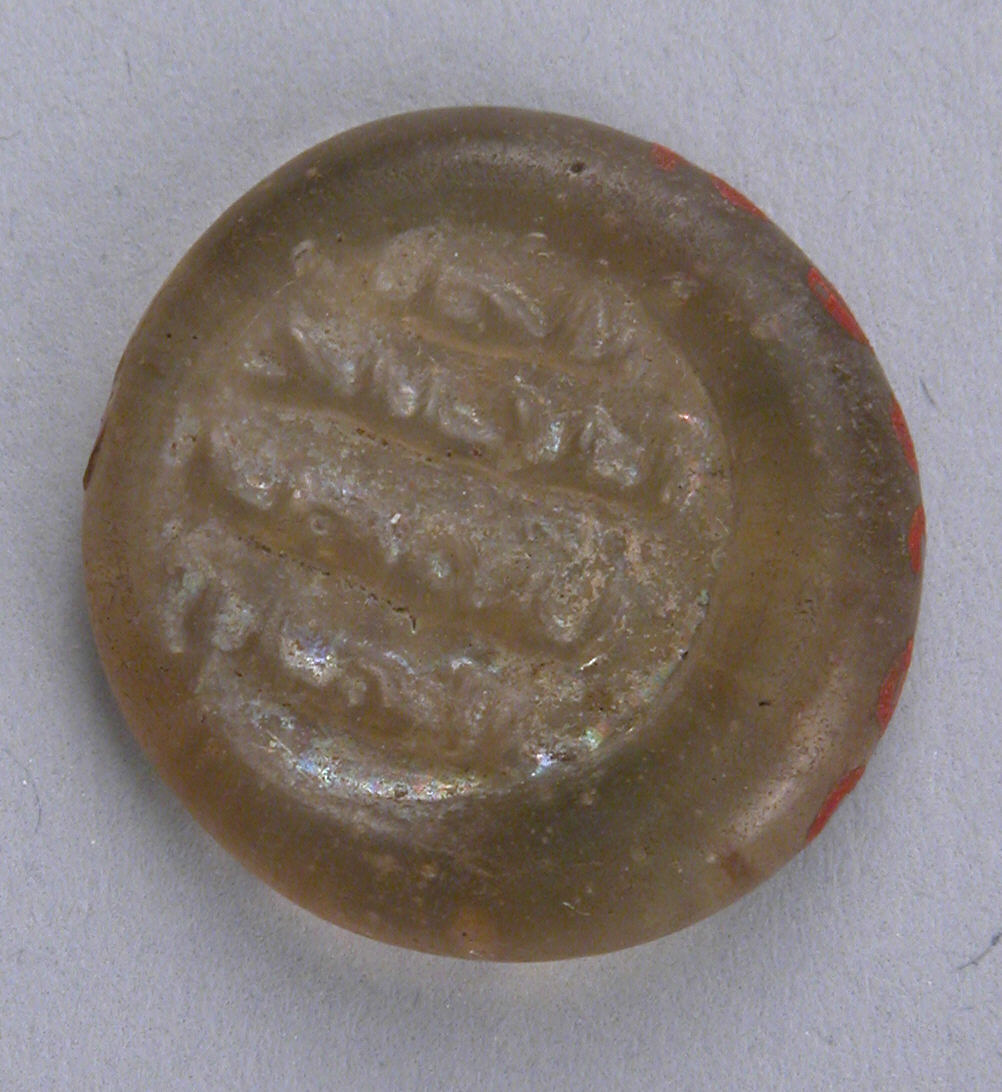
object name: coin weight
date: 801-1000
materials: glass